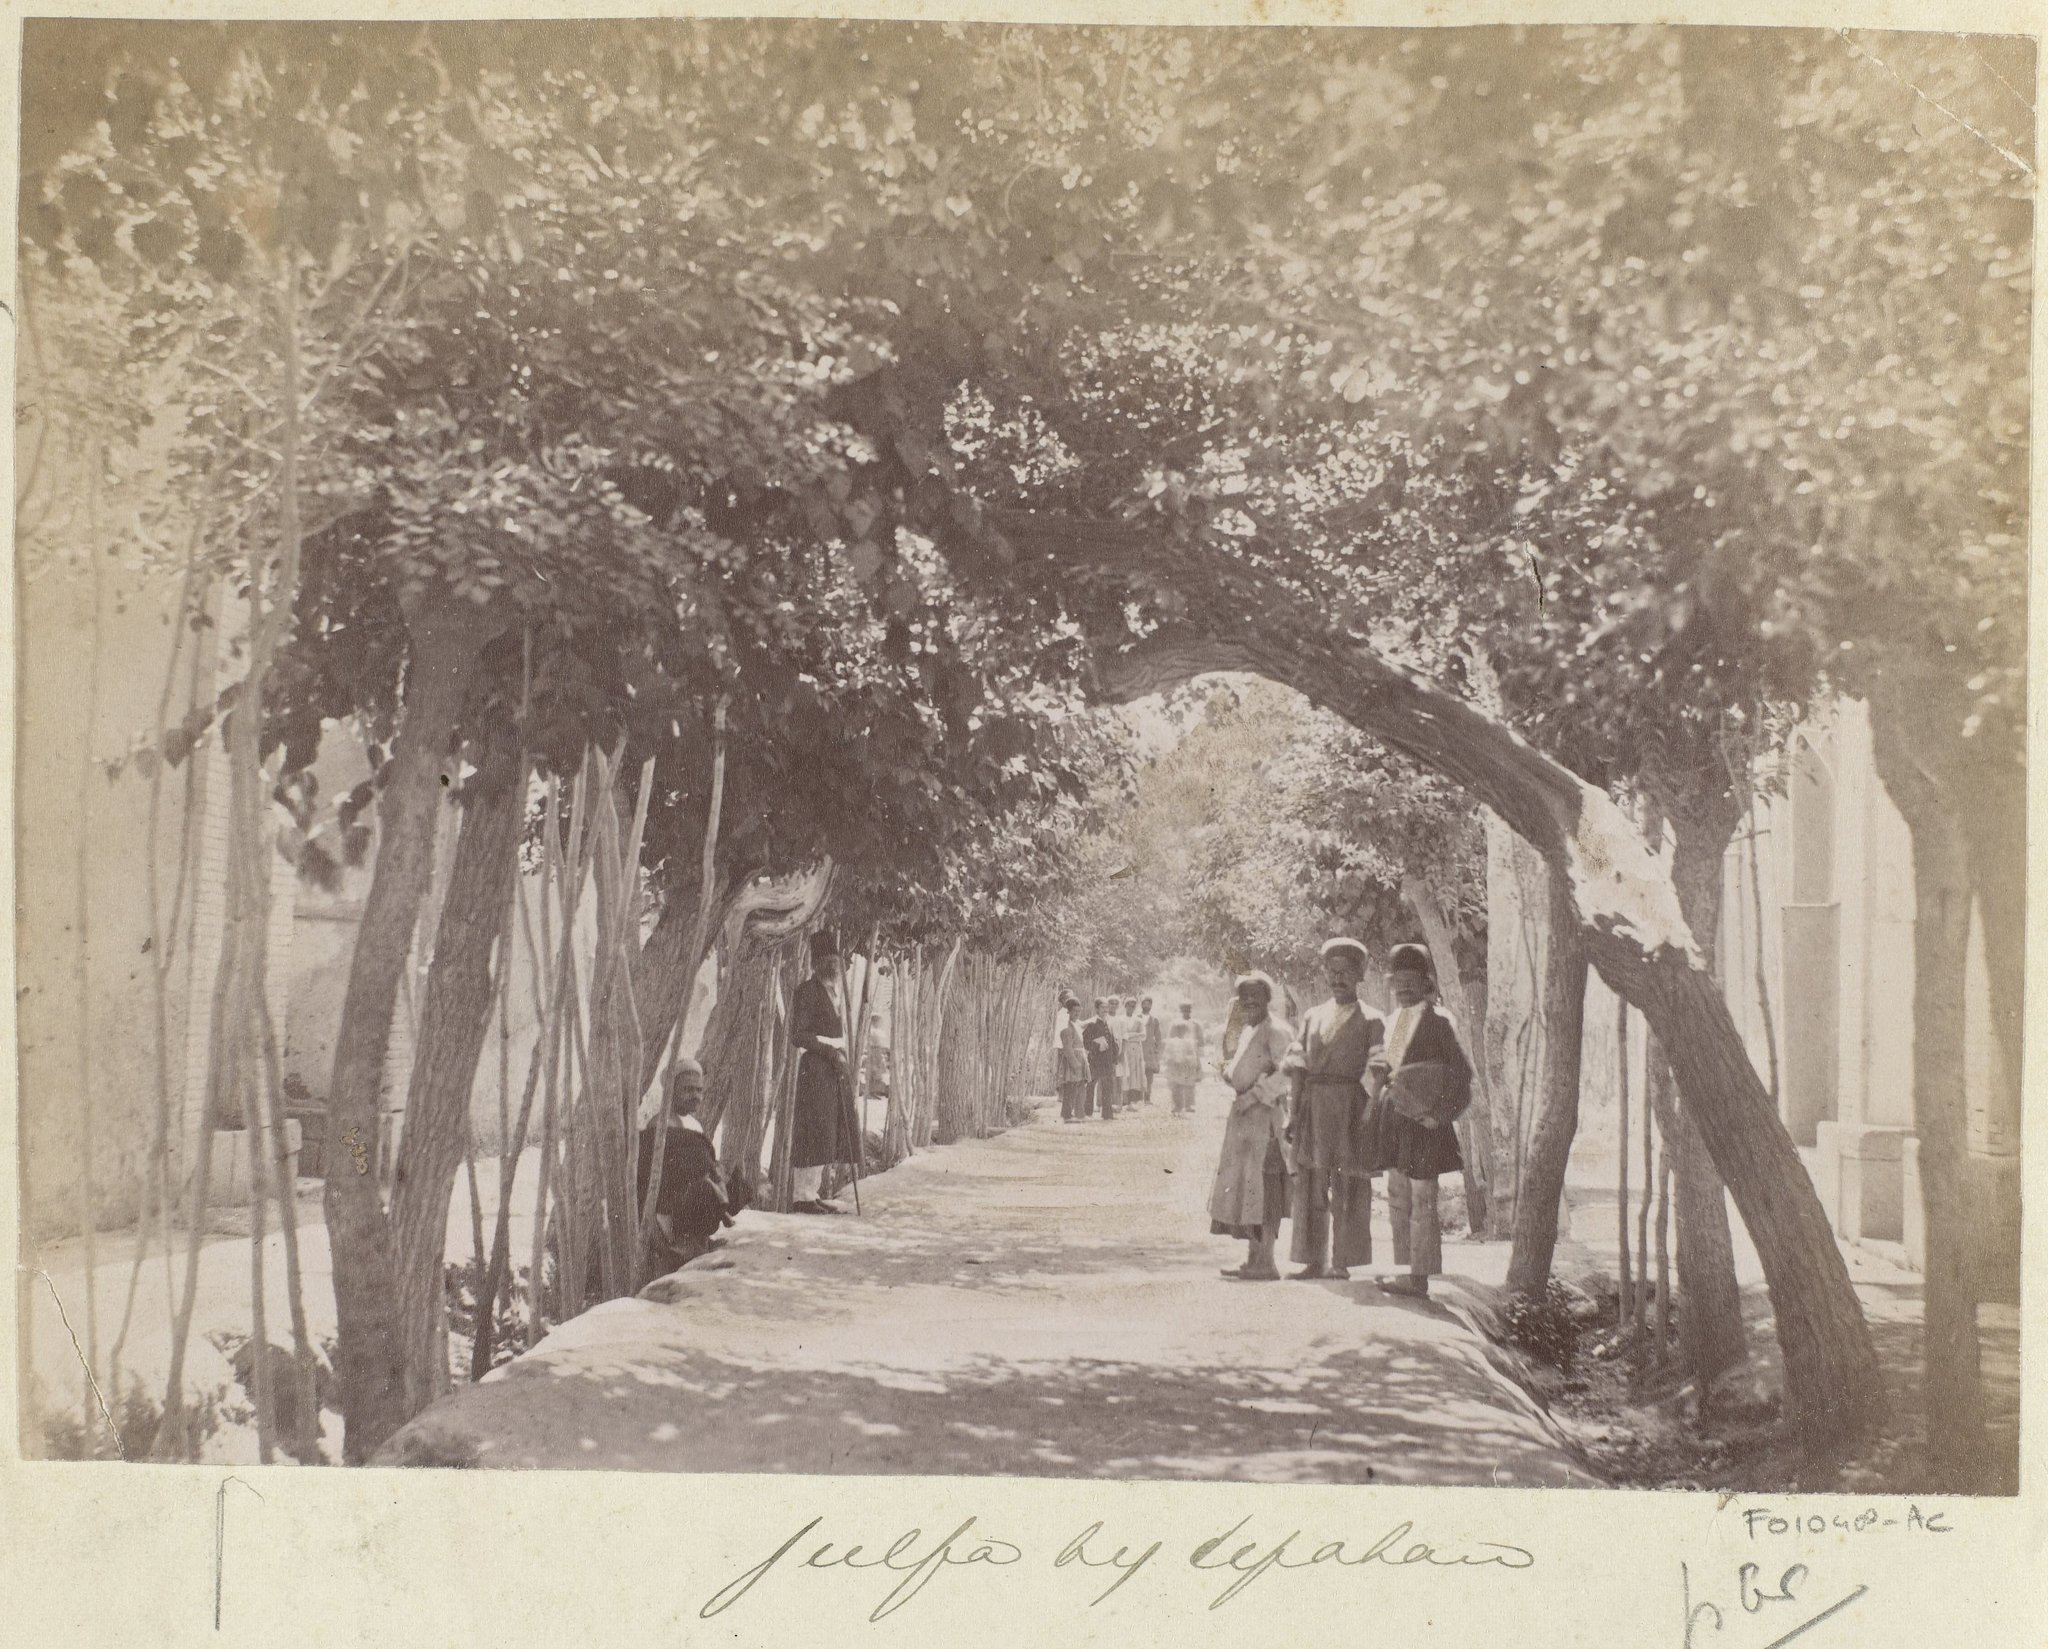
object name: photograph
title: [(...)]ulfa bij Isfahan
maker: antoine sevruguin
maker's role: fotograaf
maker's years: 1840-1933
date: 1880-1895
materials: paper, photographic support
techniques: albumen print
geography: iran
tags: forest path or lane, persia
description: Onderdeel van Reisalbum van H. Dunlop met foto's van bezienswaardigheden in Perzië, Schotland, Duitsland, Rusland, China en Canada.